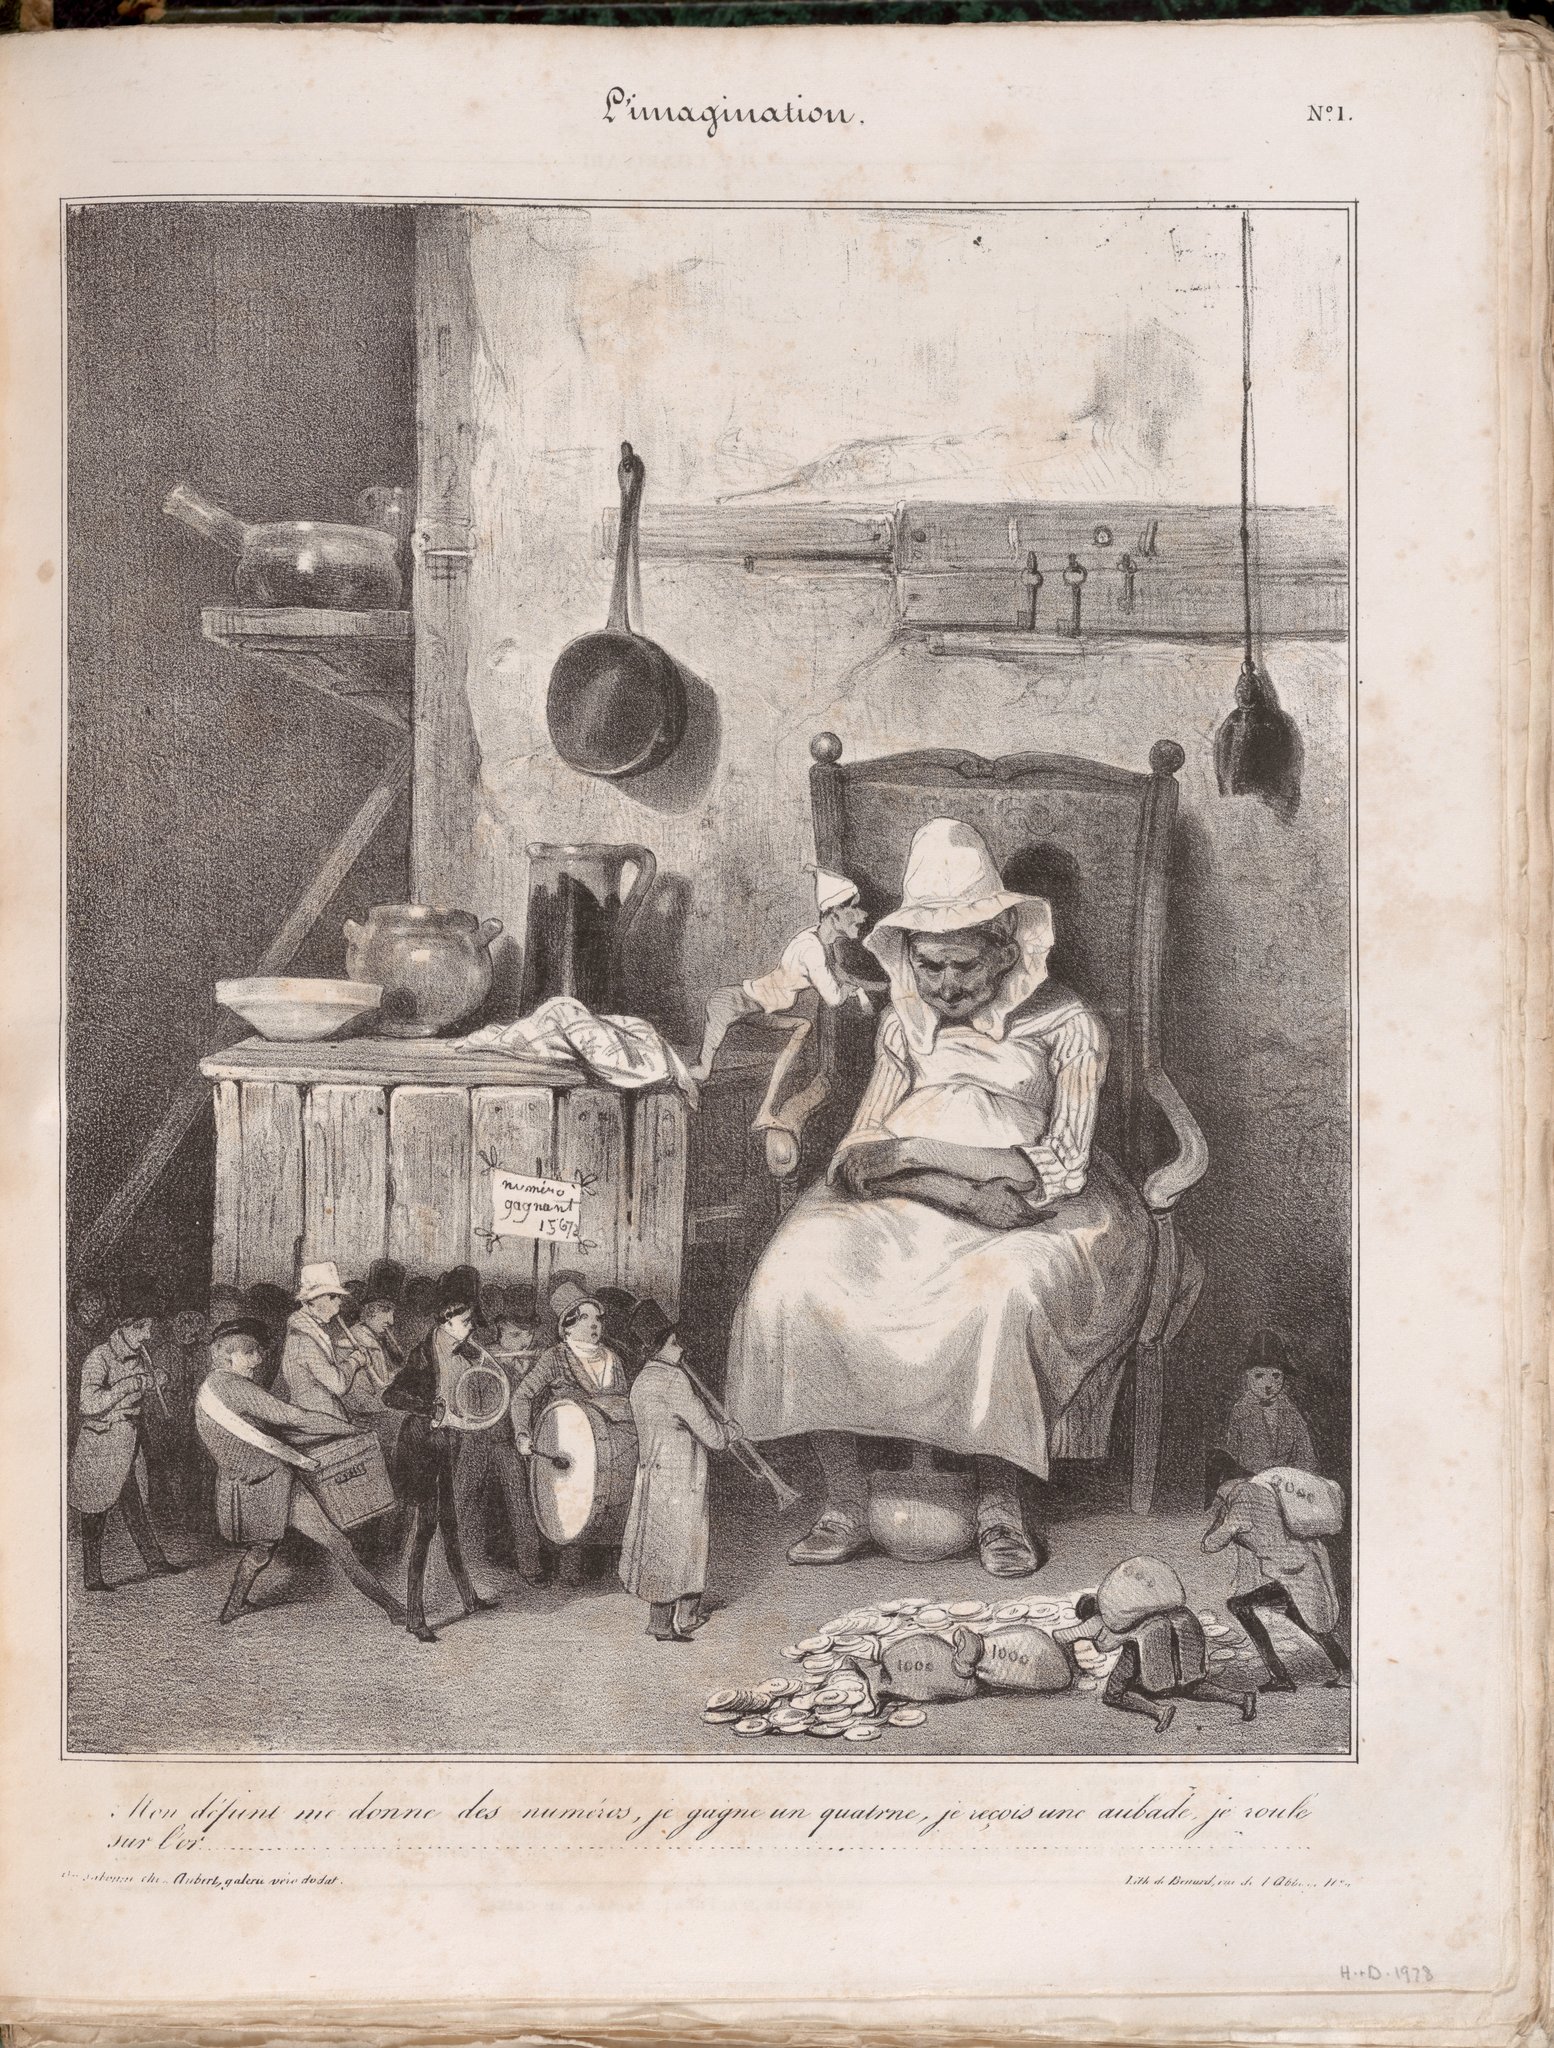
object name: print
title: My deceased husband gave me tickets…, from ‘L’Imagination’ published in Le Charivari January 14, 1833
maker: honoré daumier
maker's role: artist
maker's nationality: french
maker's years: 1808-1879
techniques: lithograph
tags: satire,men,women,musicians